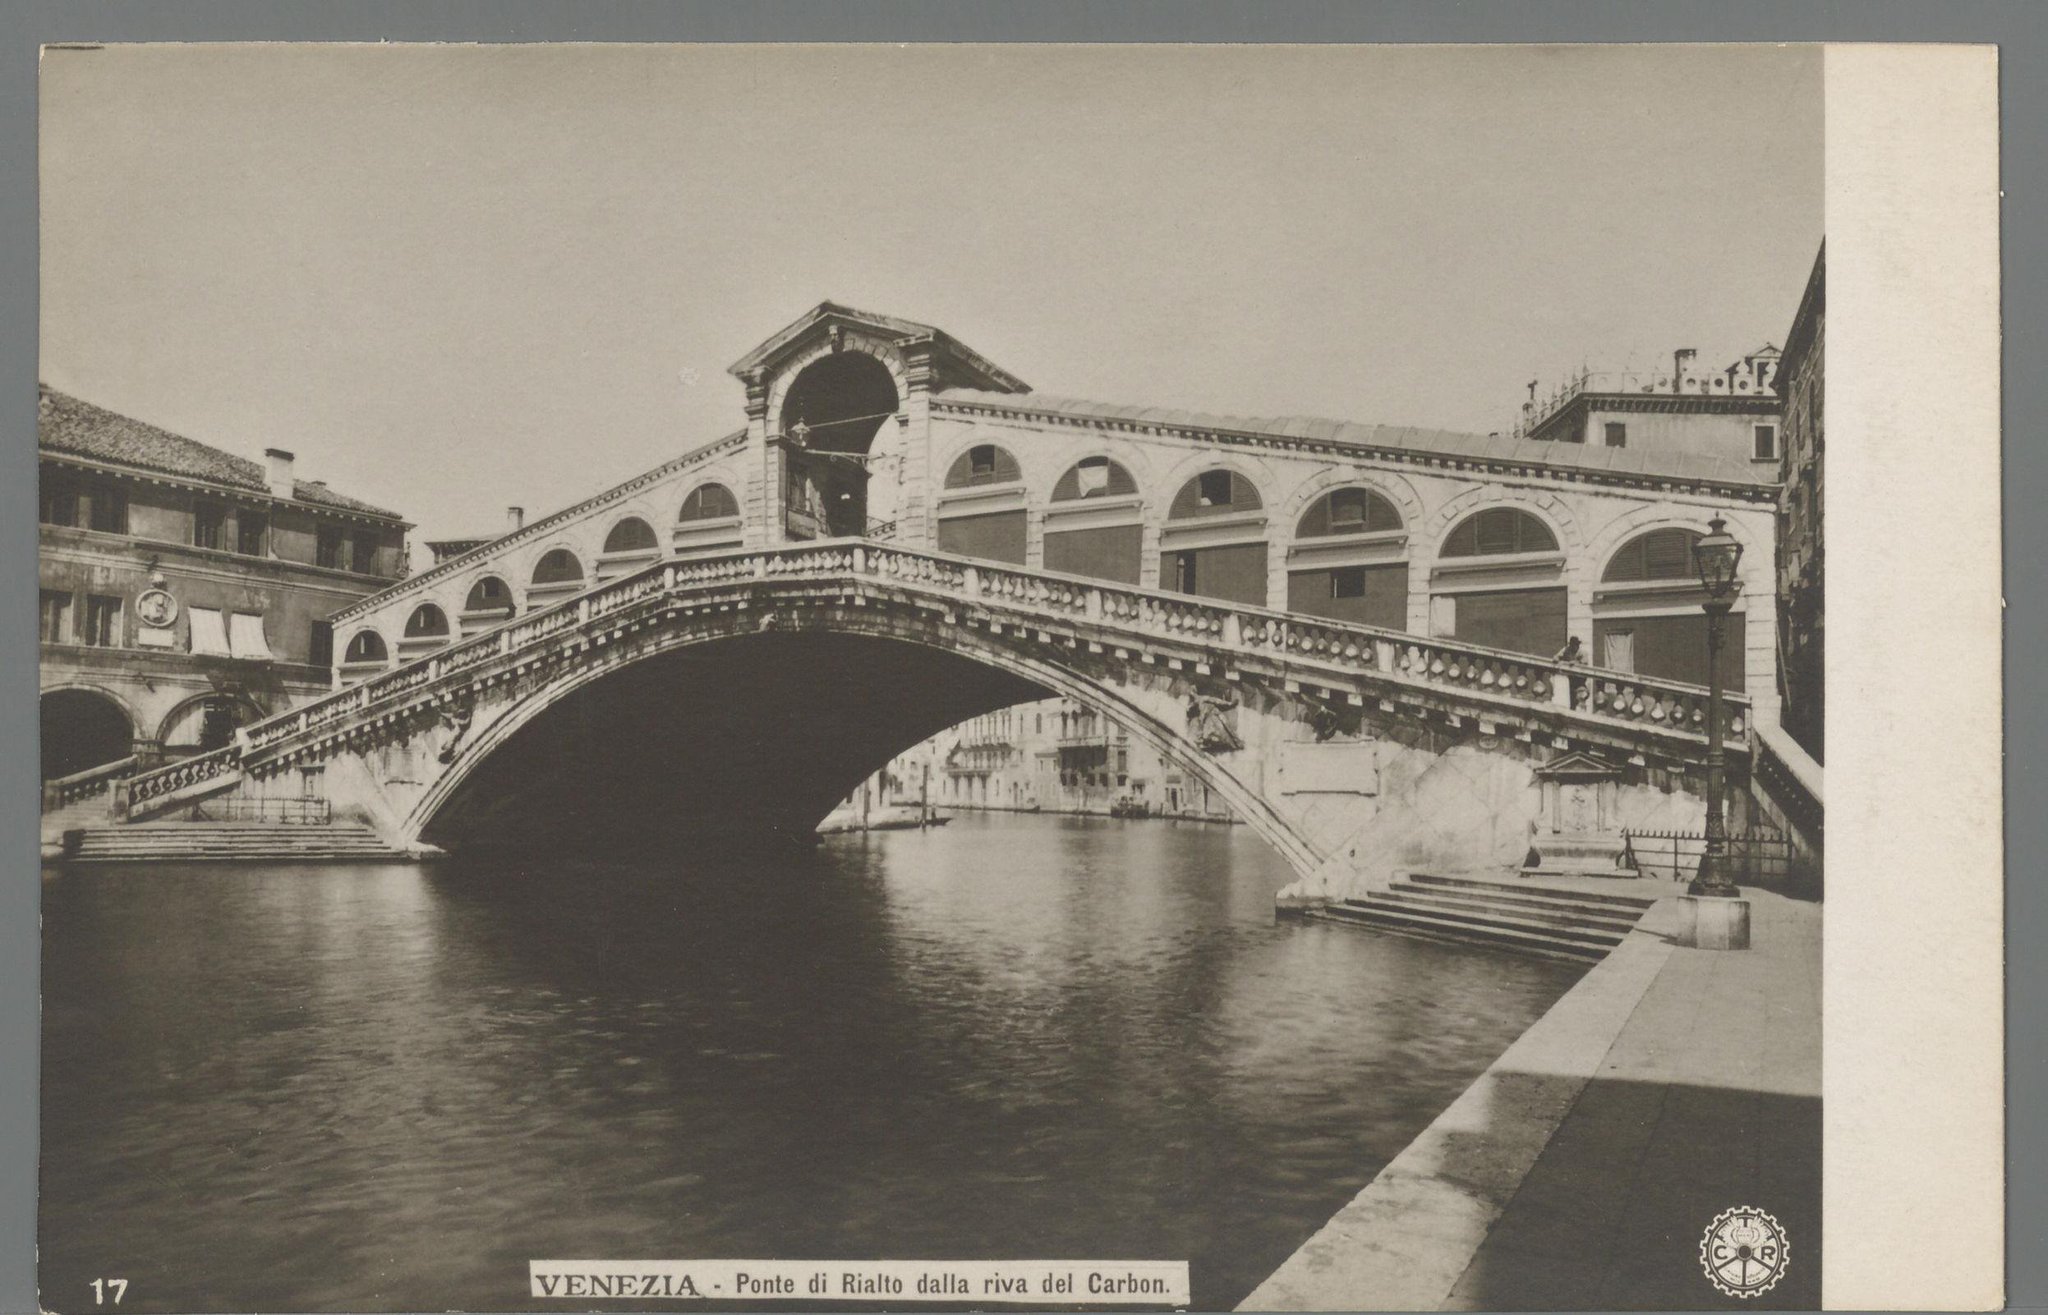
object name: ansichtkaart, prentbriefkaart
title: Venezia. Ponte di Rialto dalla riva del Carbon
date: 1906-1920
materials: photographic support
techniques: photography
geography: venice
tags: bridge in city with structures, i.e. shops, houses, e.g. ponte vecchio in florence (+ city(-scape) with figures, staffage), canal